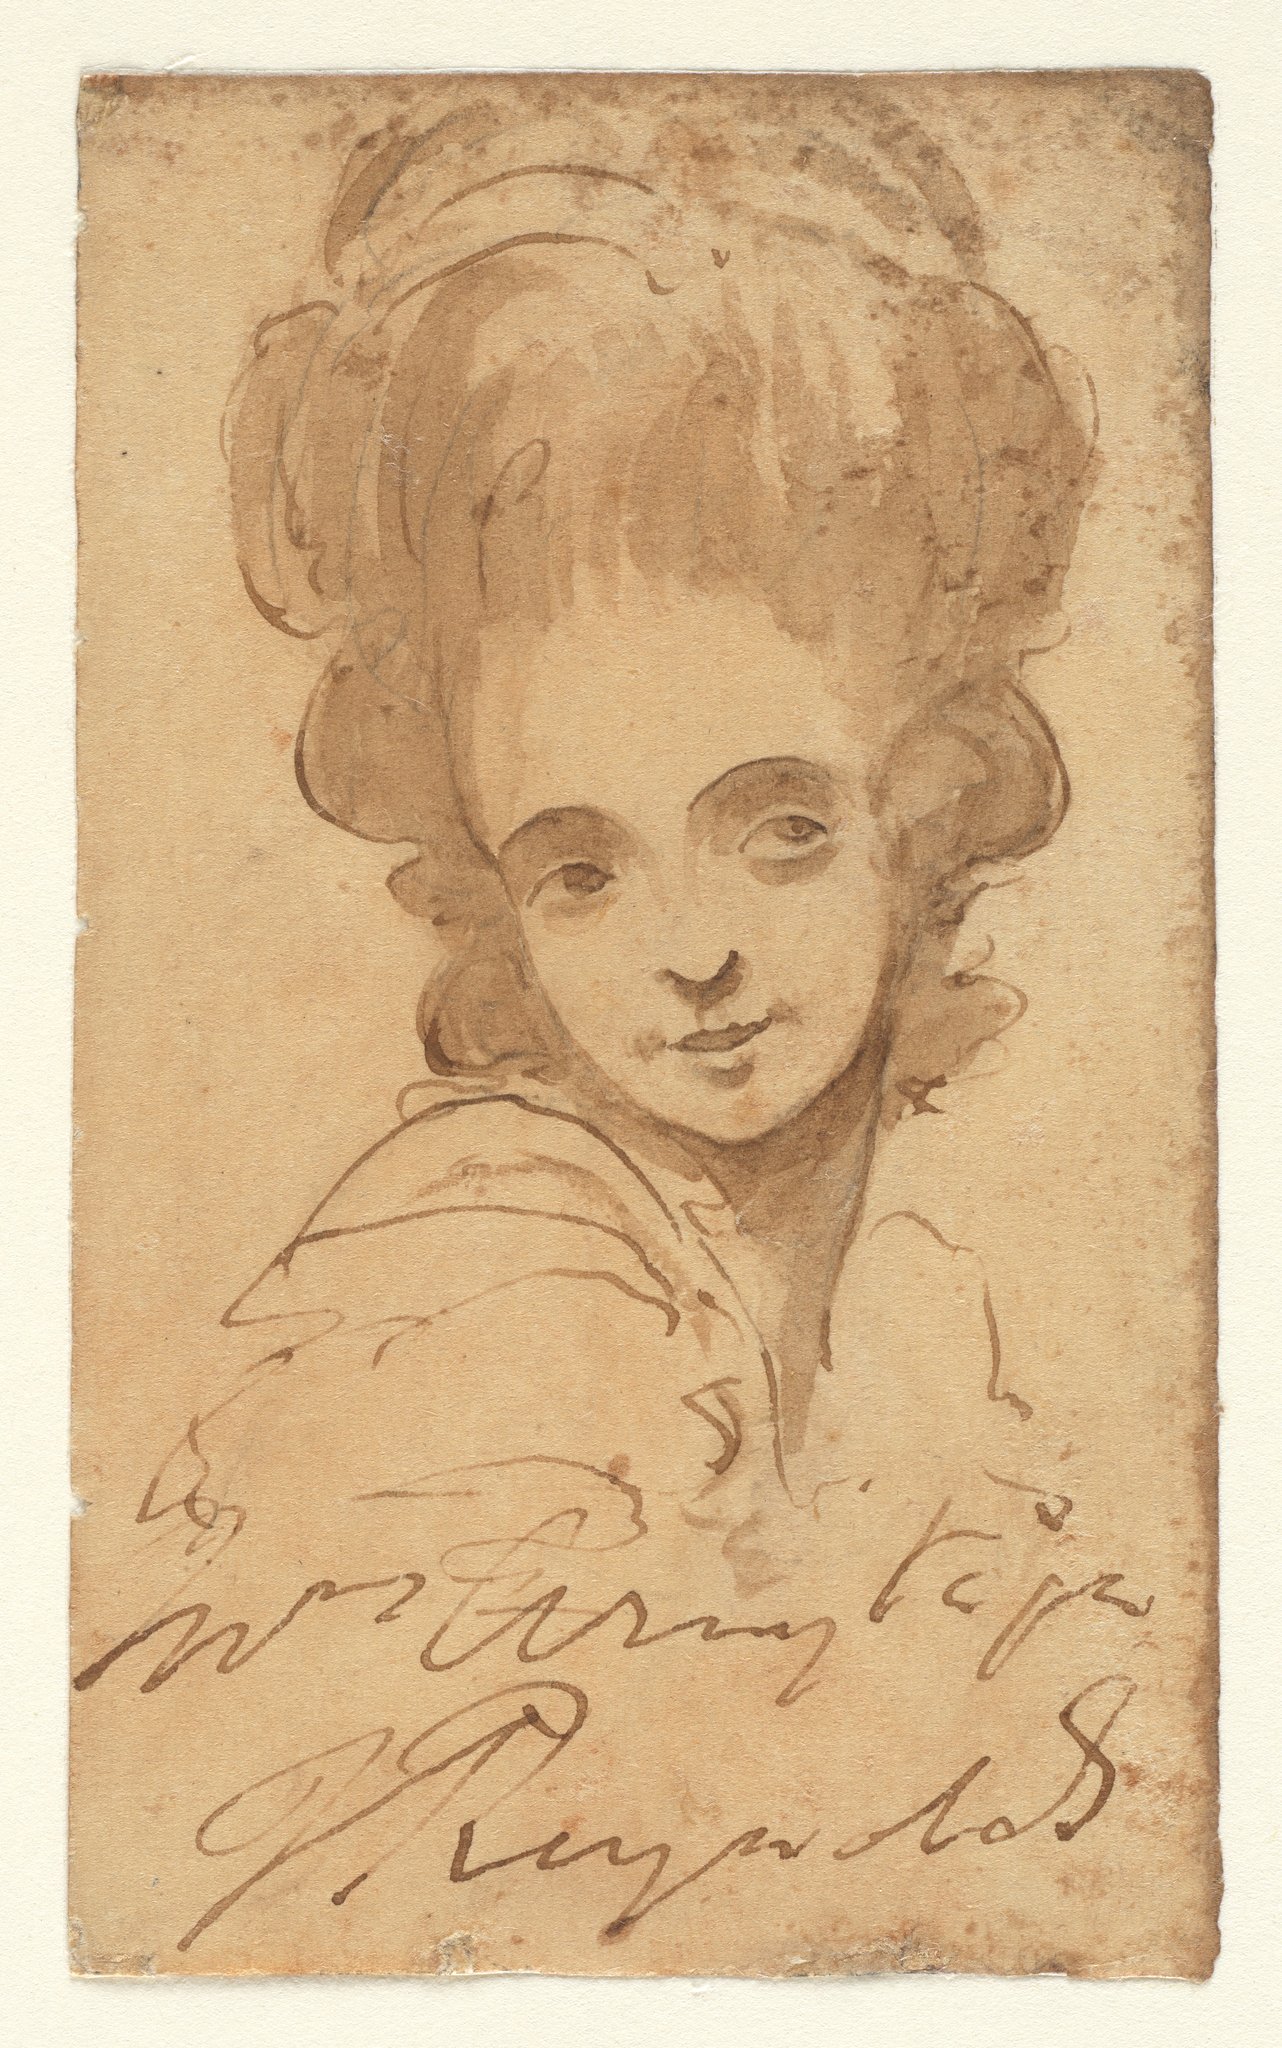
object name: drawing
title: Head of a Lady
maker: Anonymous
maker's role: artist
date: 1801-1900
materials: ink, paper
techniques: pen, wash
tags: women